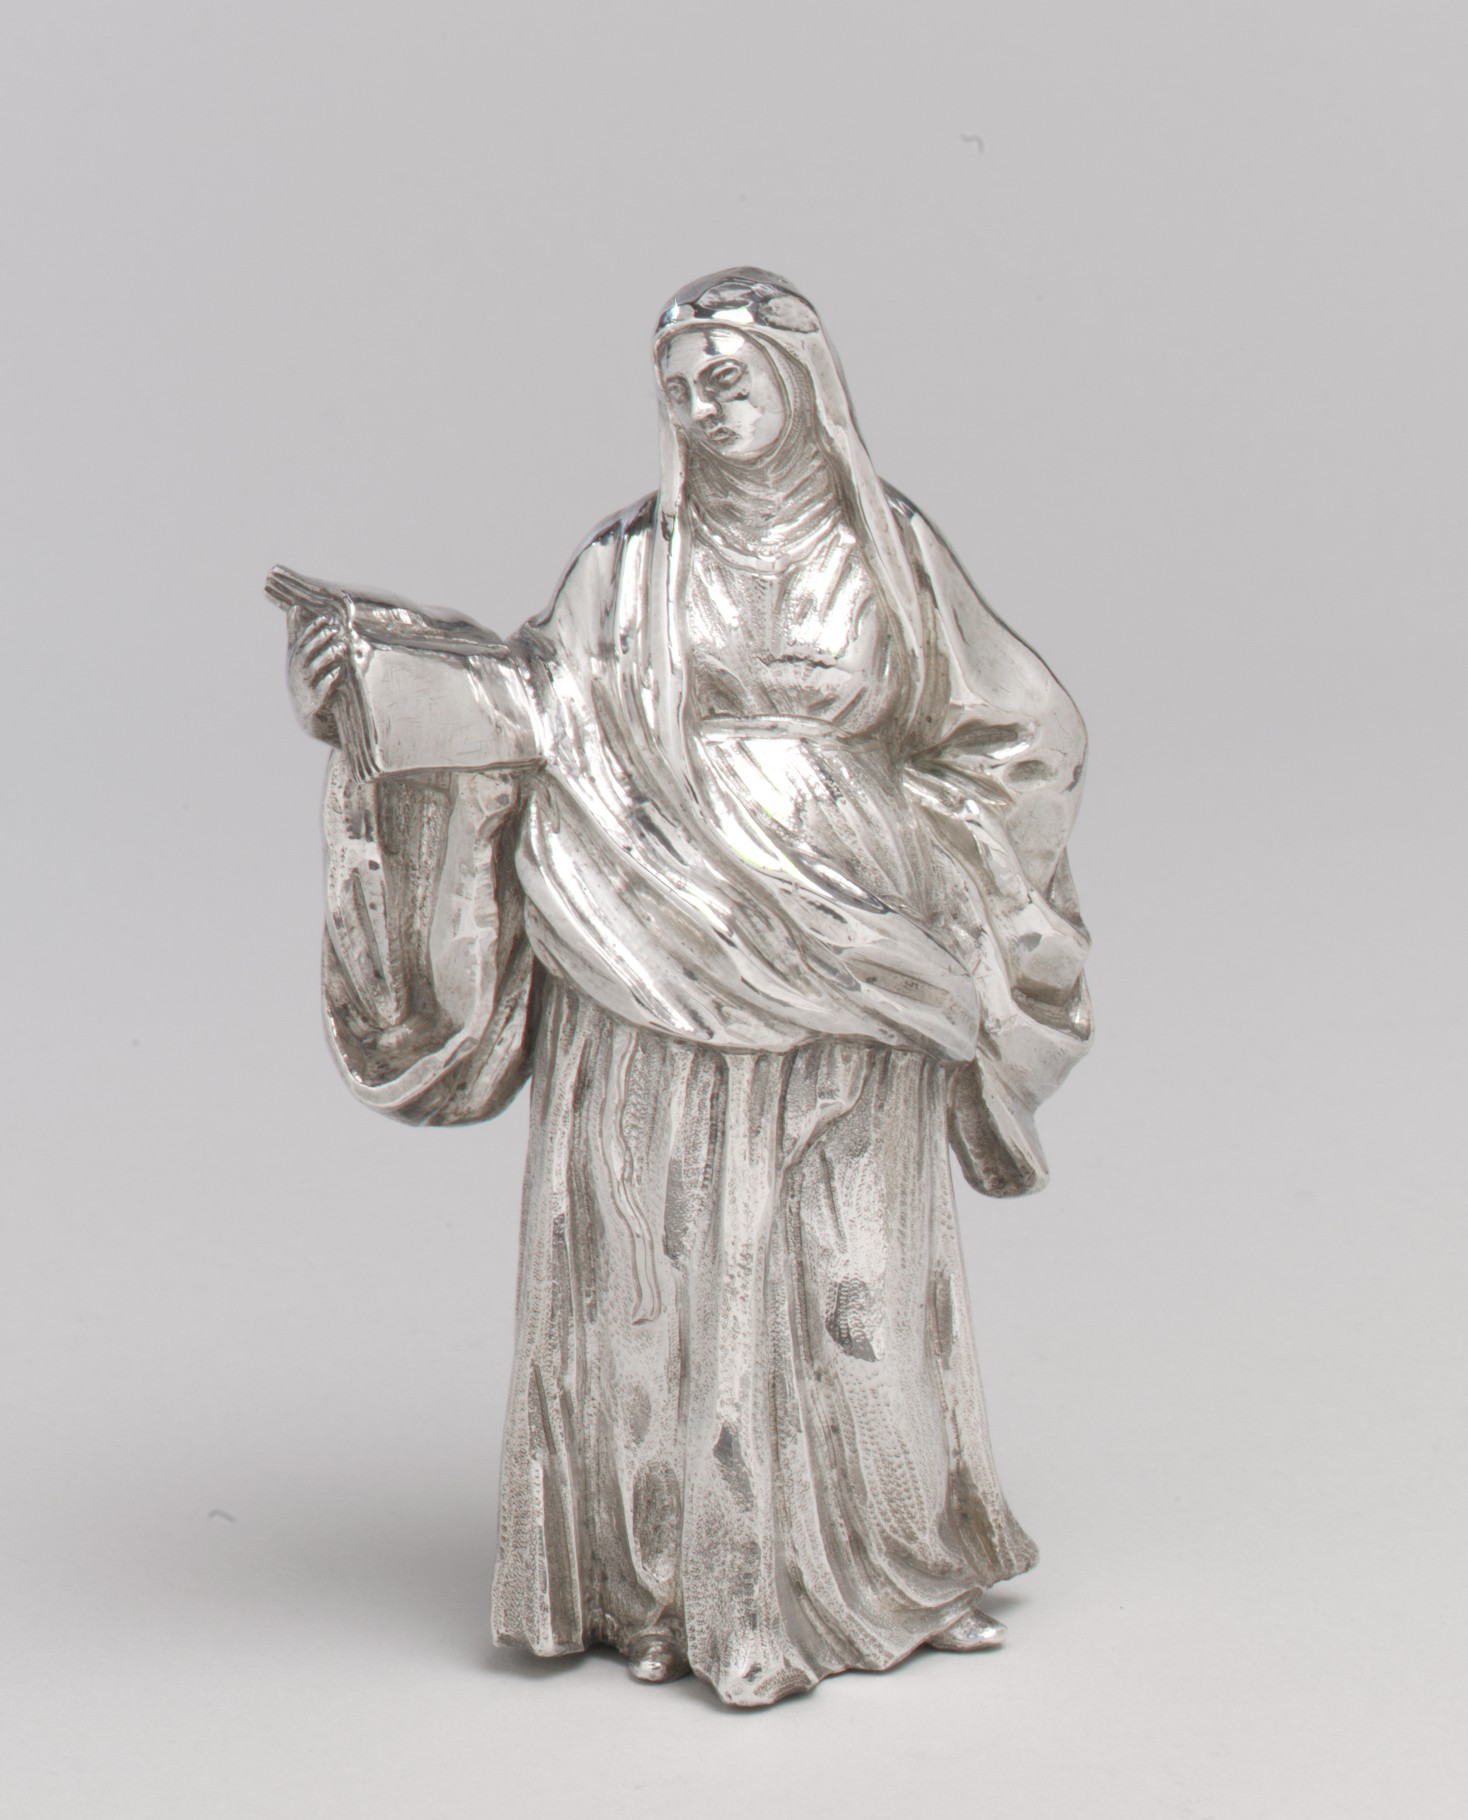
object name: relief statuette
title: Saint Felicity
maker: giacomo serpotta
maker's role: artist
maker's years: 1656-1732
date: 1762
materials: silver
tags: books,women,saints